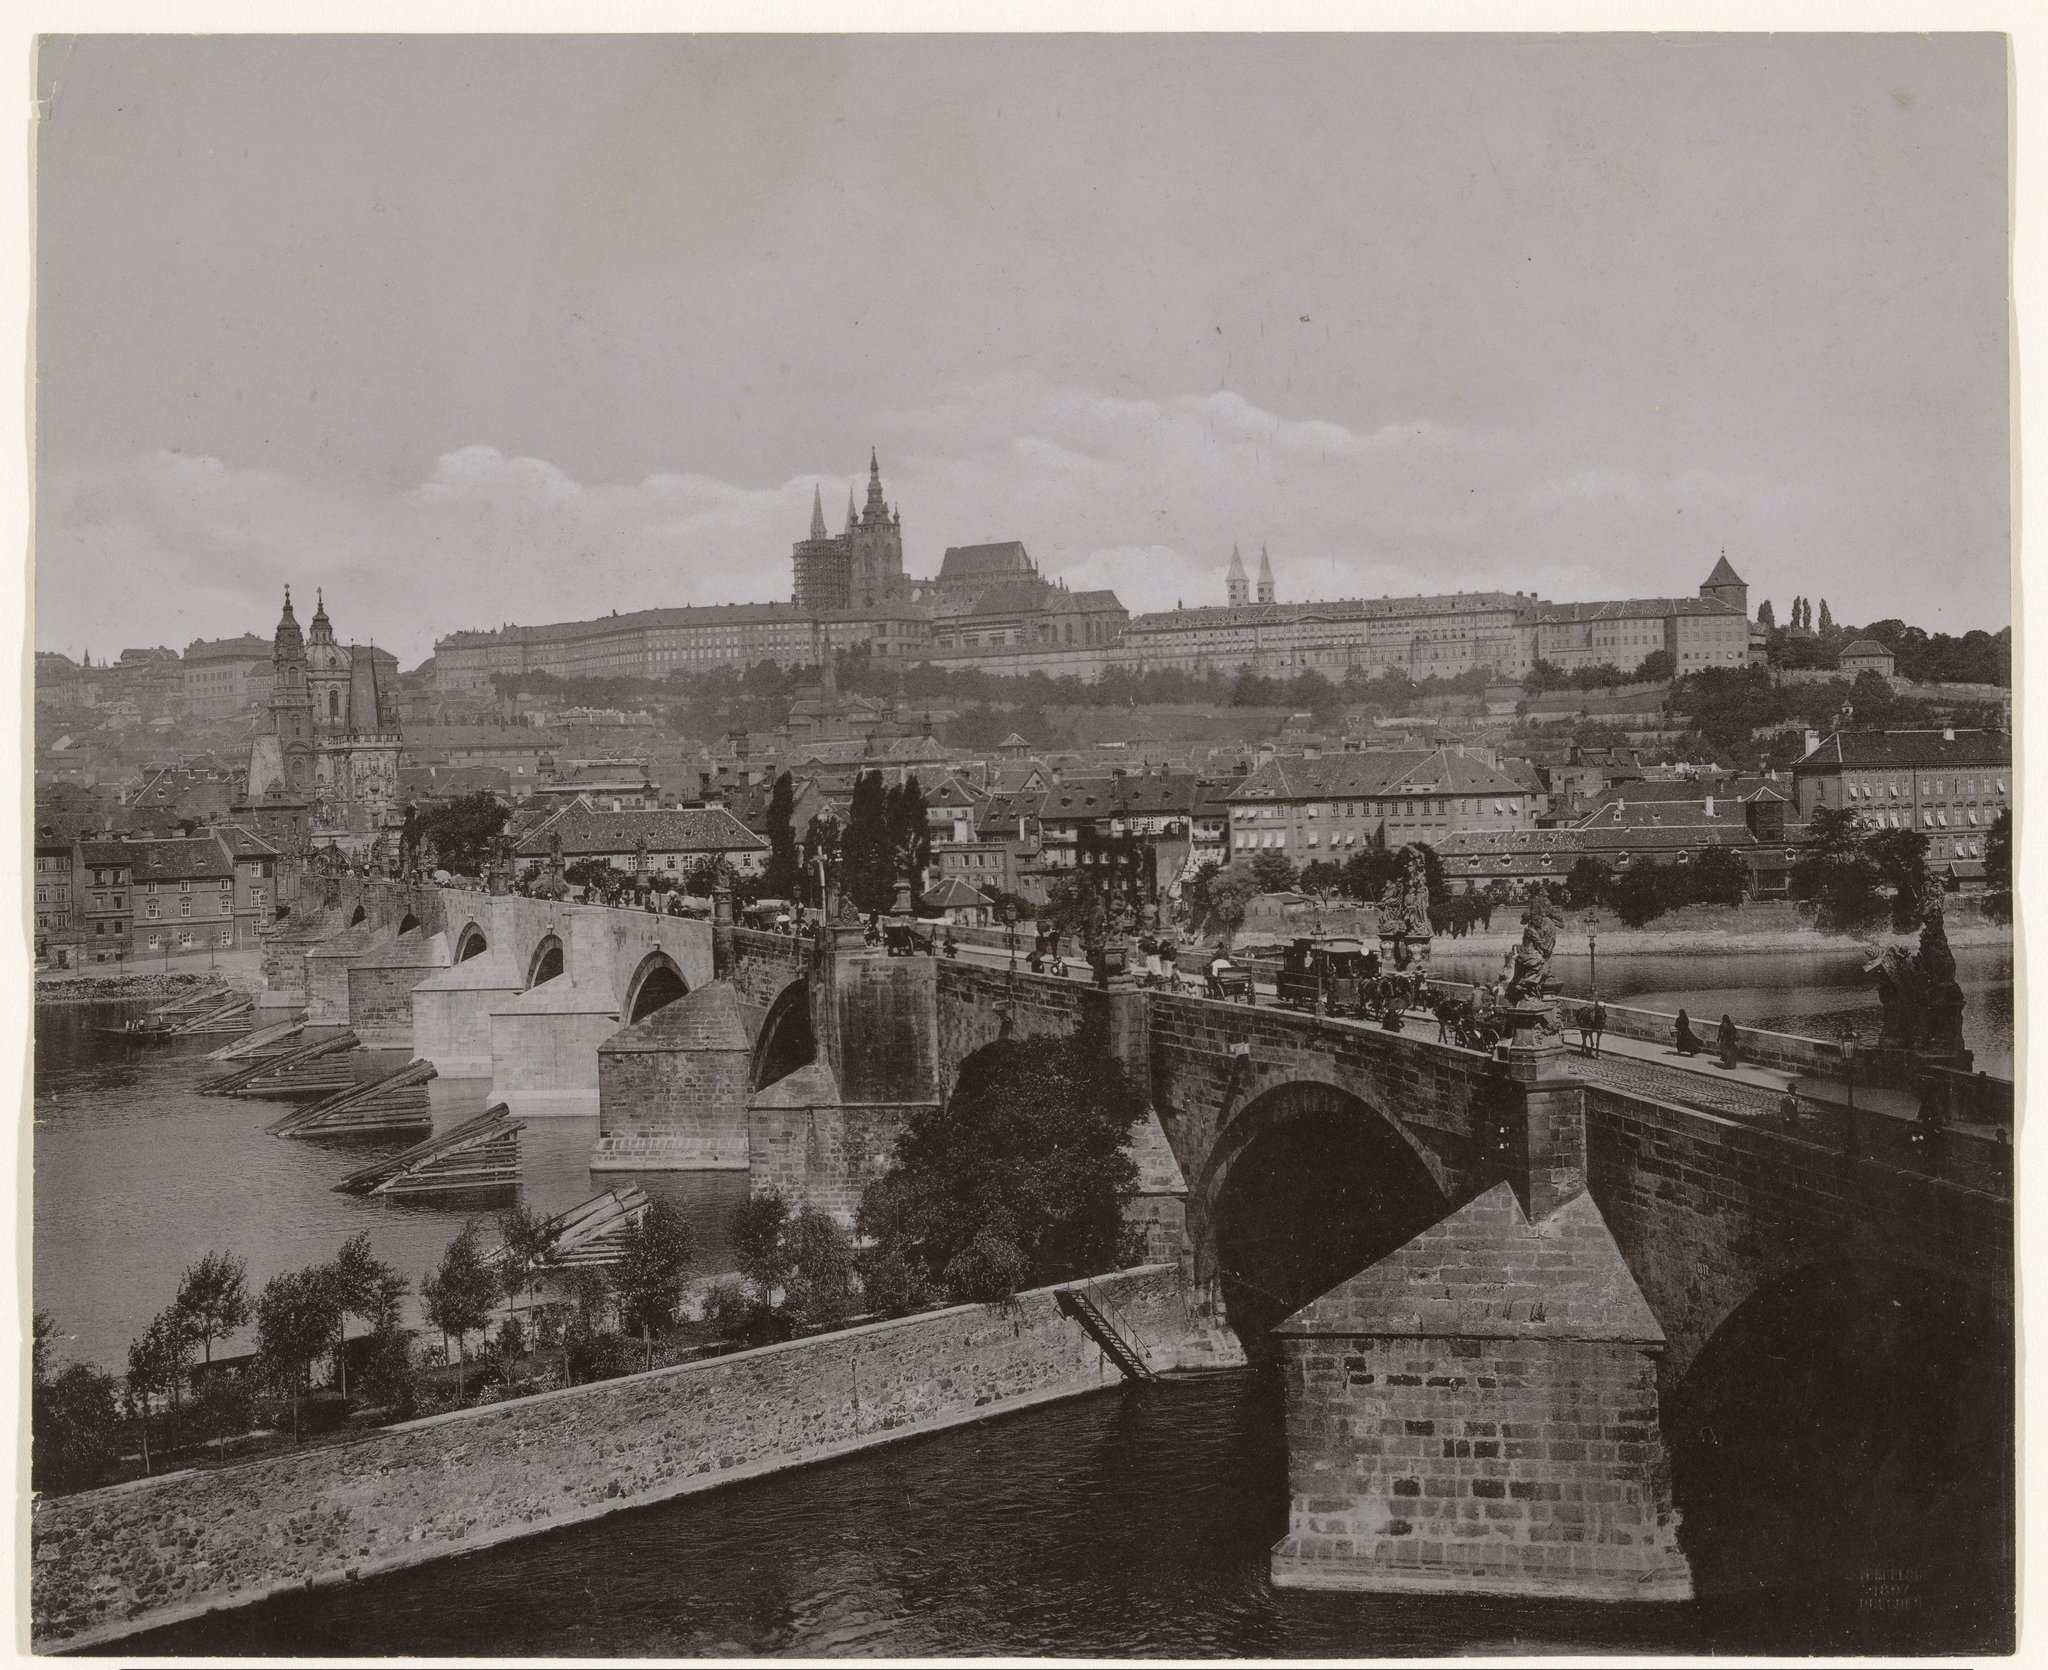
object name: photomechanical print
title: Karelsbrug gezien richting Malá Strana en Hradčany, Praag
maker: Anonymous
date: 1897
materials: paper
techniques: photograph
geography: dresden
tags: city-view in general; 'veduta', river, bridge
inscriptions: check stamp: ‘Stengel & Co/ 1897/ Dresden’, inscription: ‘Praag/ 2103. Karlsbrücke und Kleinseite’, stamp: ‘Hans Mengelberg/ Utrecht’